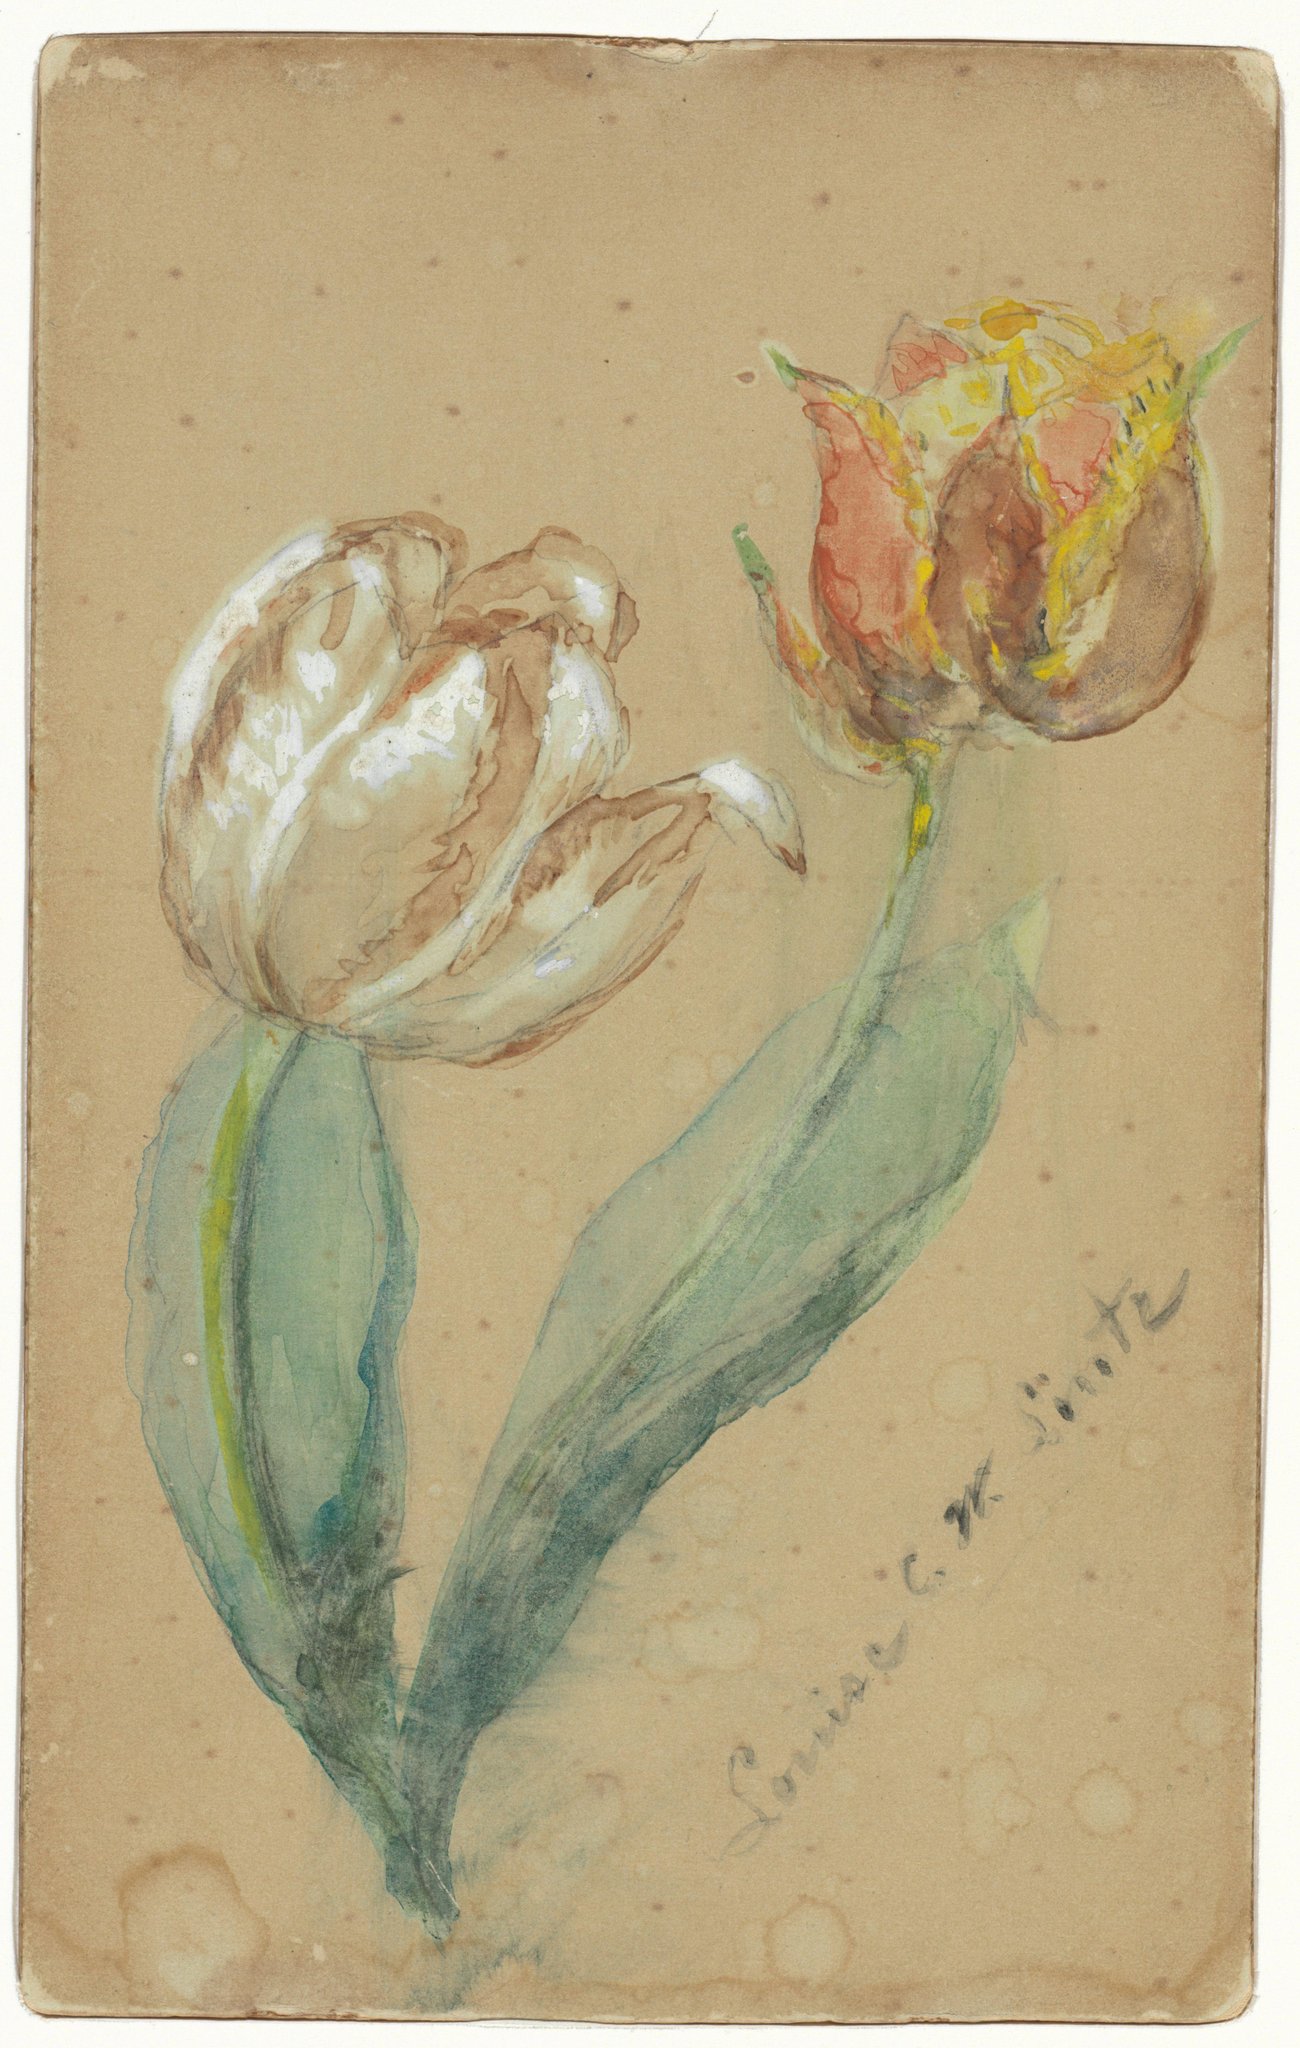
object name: drawing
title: Twee tulpen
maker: louise lintz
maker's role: draughtsman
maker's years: 1838-1911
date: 1848-1911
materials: cardboard, pencil, watercolor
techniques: brush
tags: flowers: tulip